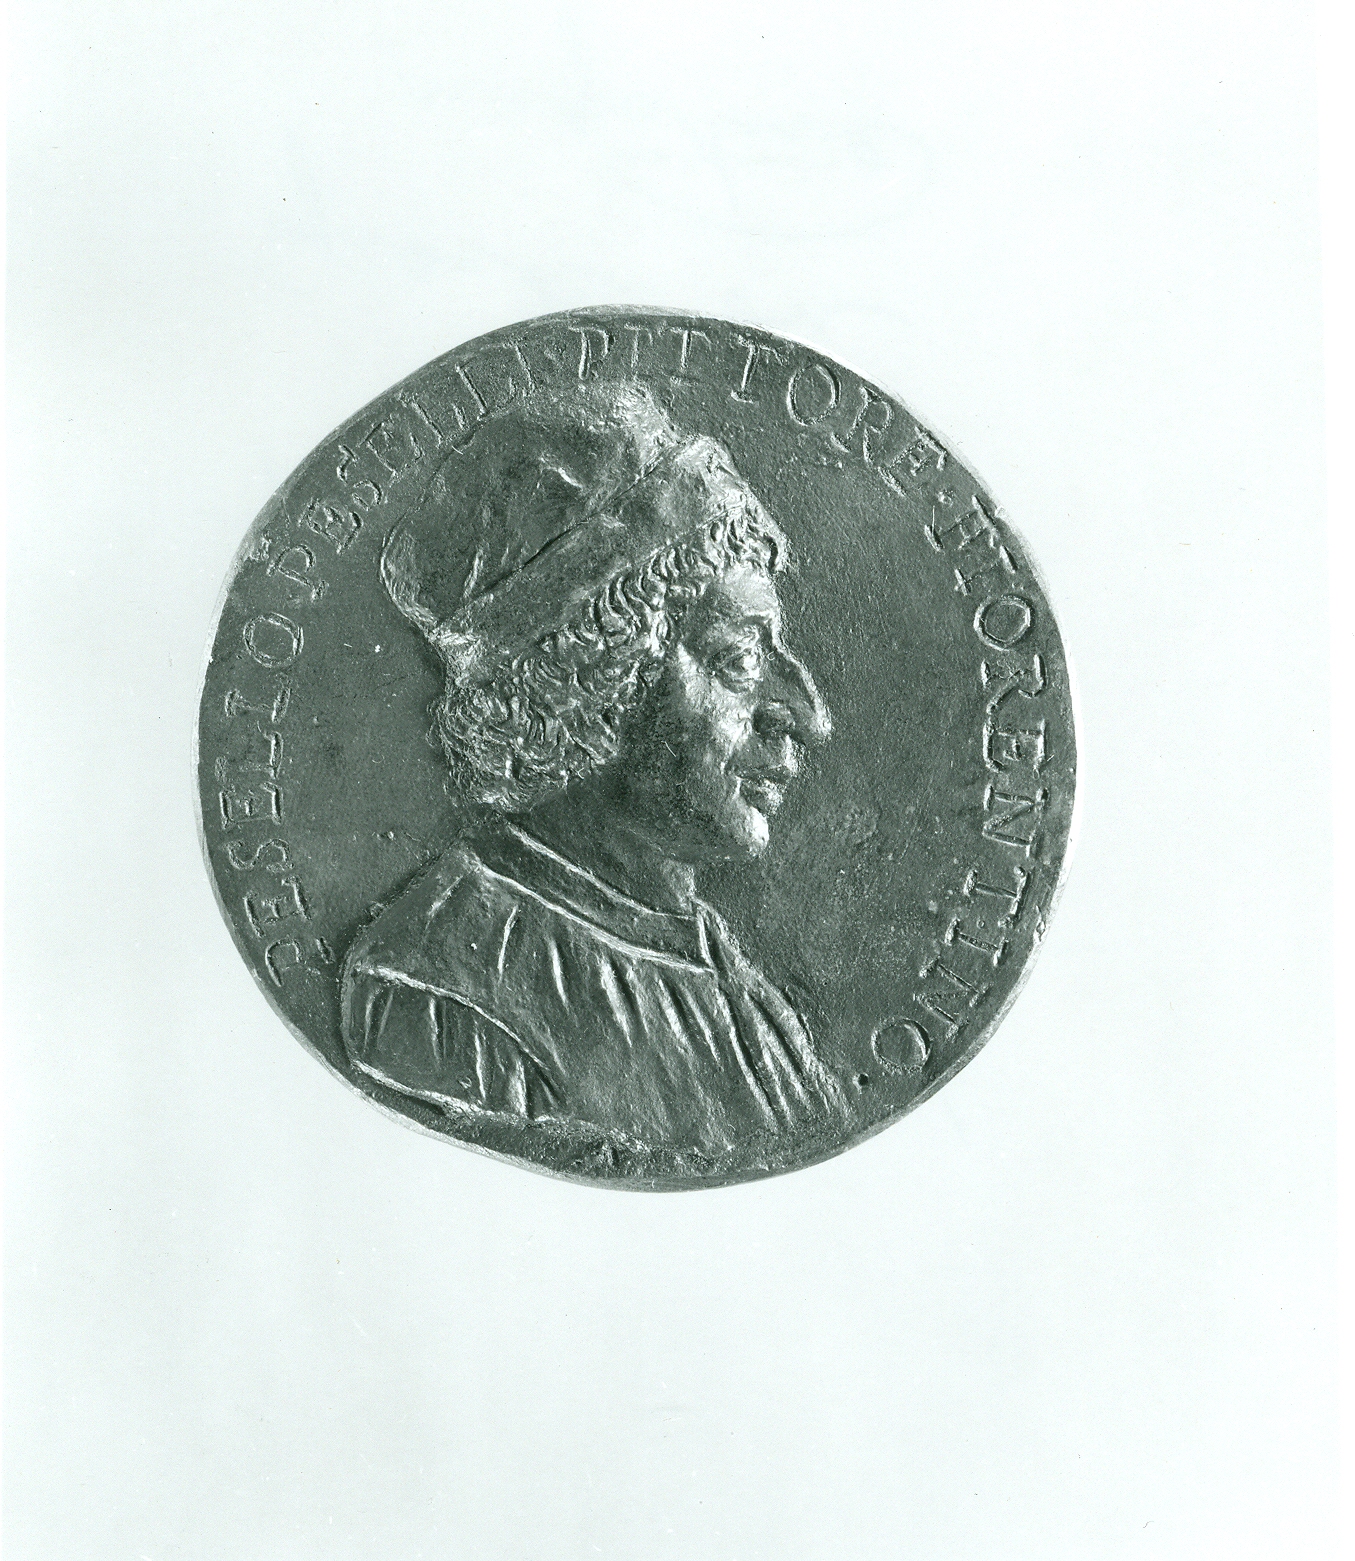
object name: medal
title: Medal: Bust of Pesello Peselli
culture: italian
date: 1801-1900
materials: bronze, copper alloy, patina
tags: men,portraits,profiles